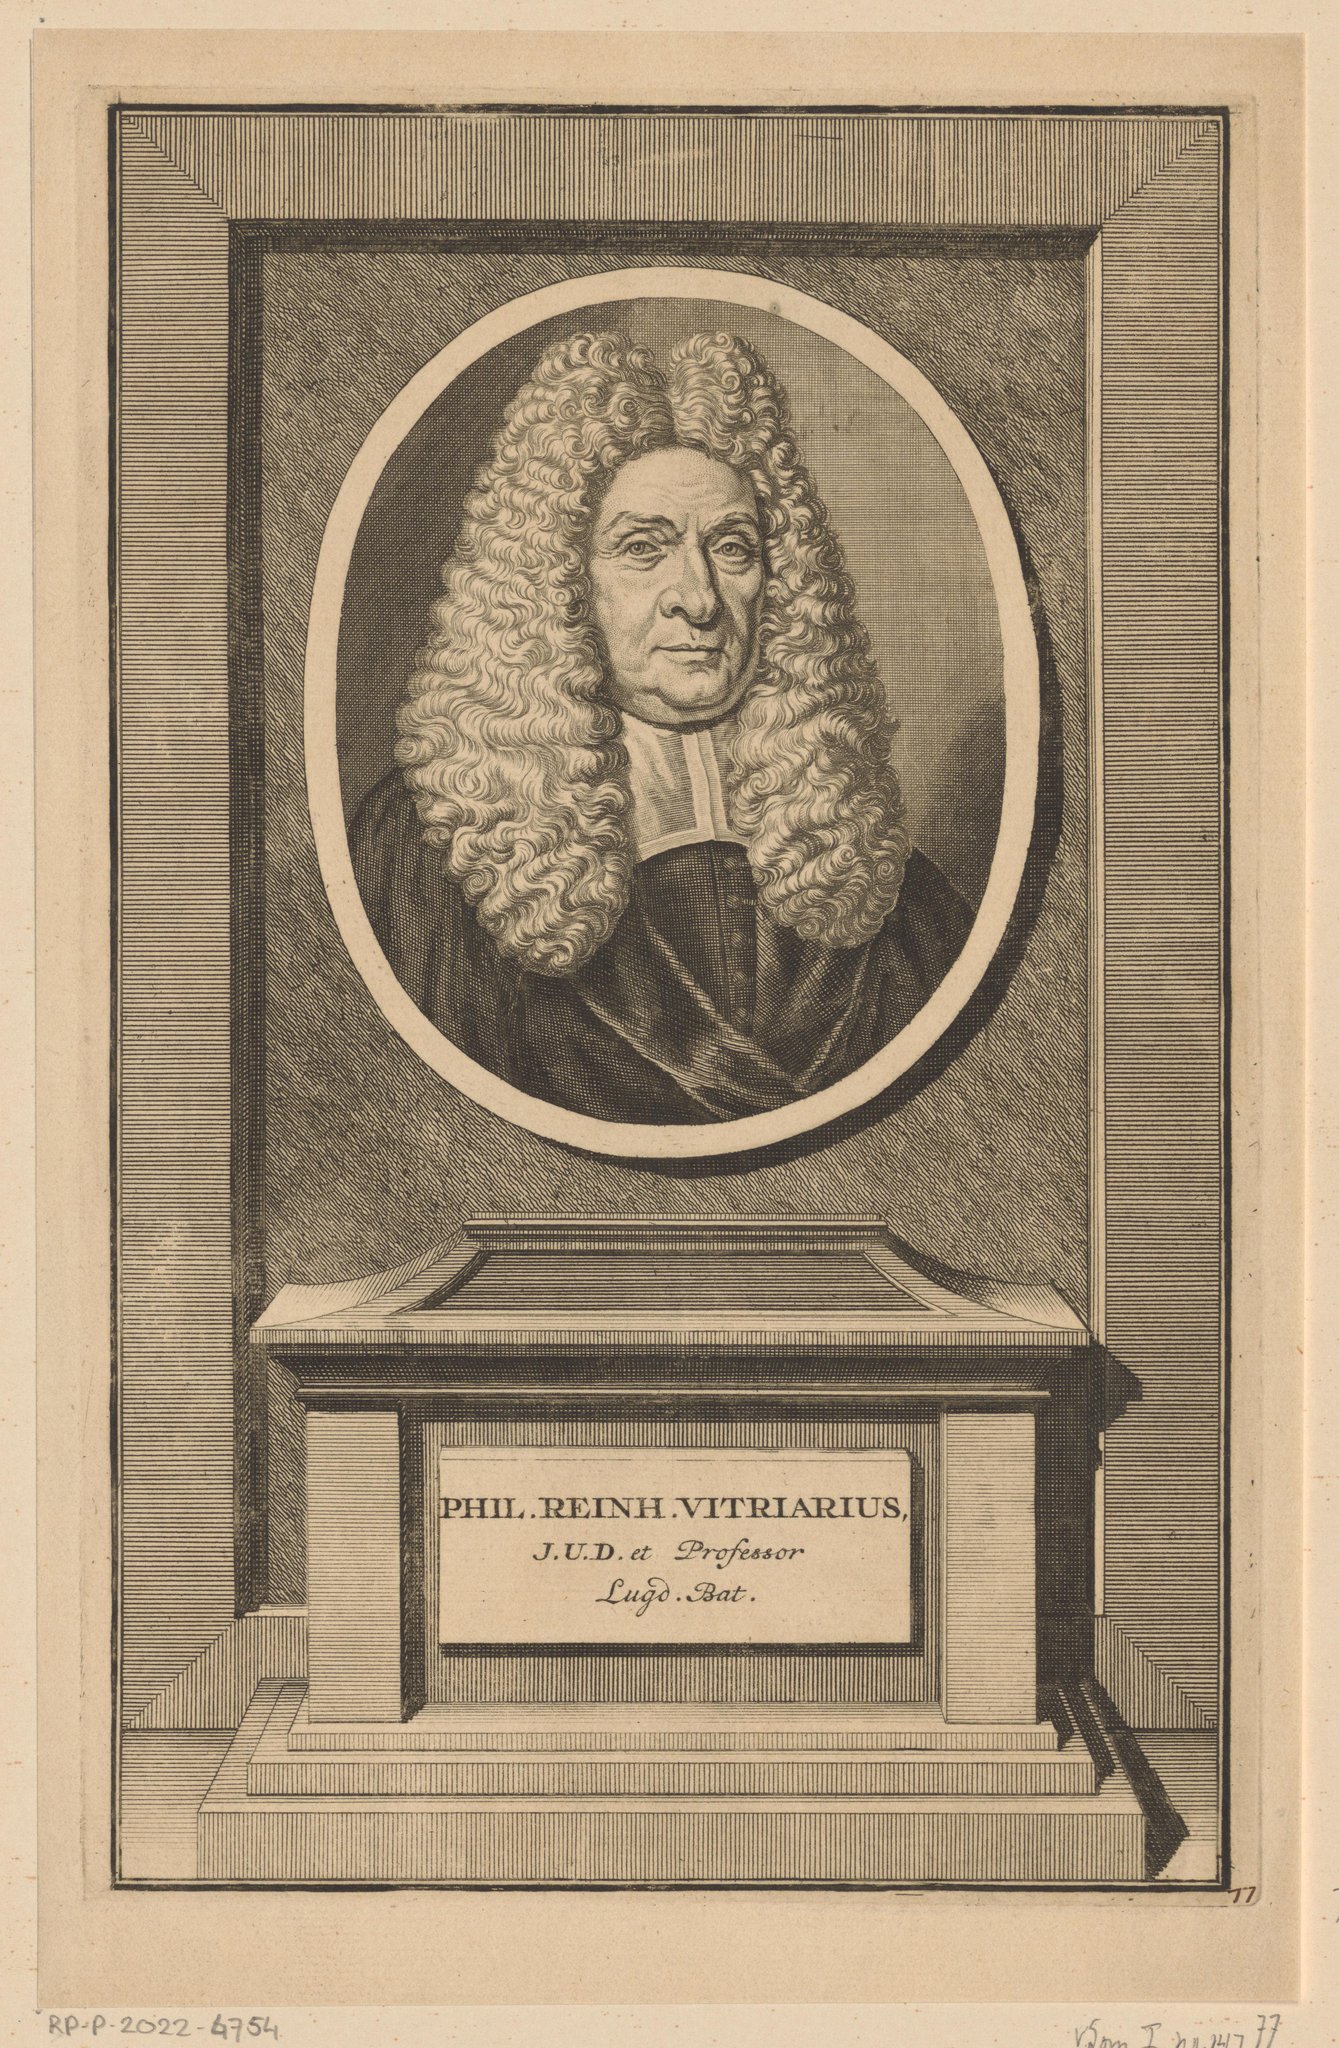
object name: print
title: Portret van Philippus Reinhardus Vitriarius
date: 1716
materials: paper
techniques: engraving, etching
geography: northern netherlands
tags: scholar, philosopher, historical persons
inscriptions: number: ‘77’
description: Rechtsonder handgeschreven genummerd: 77.